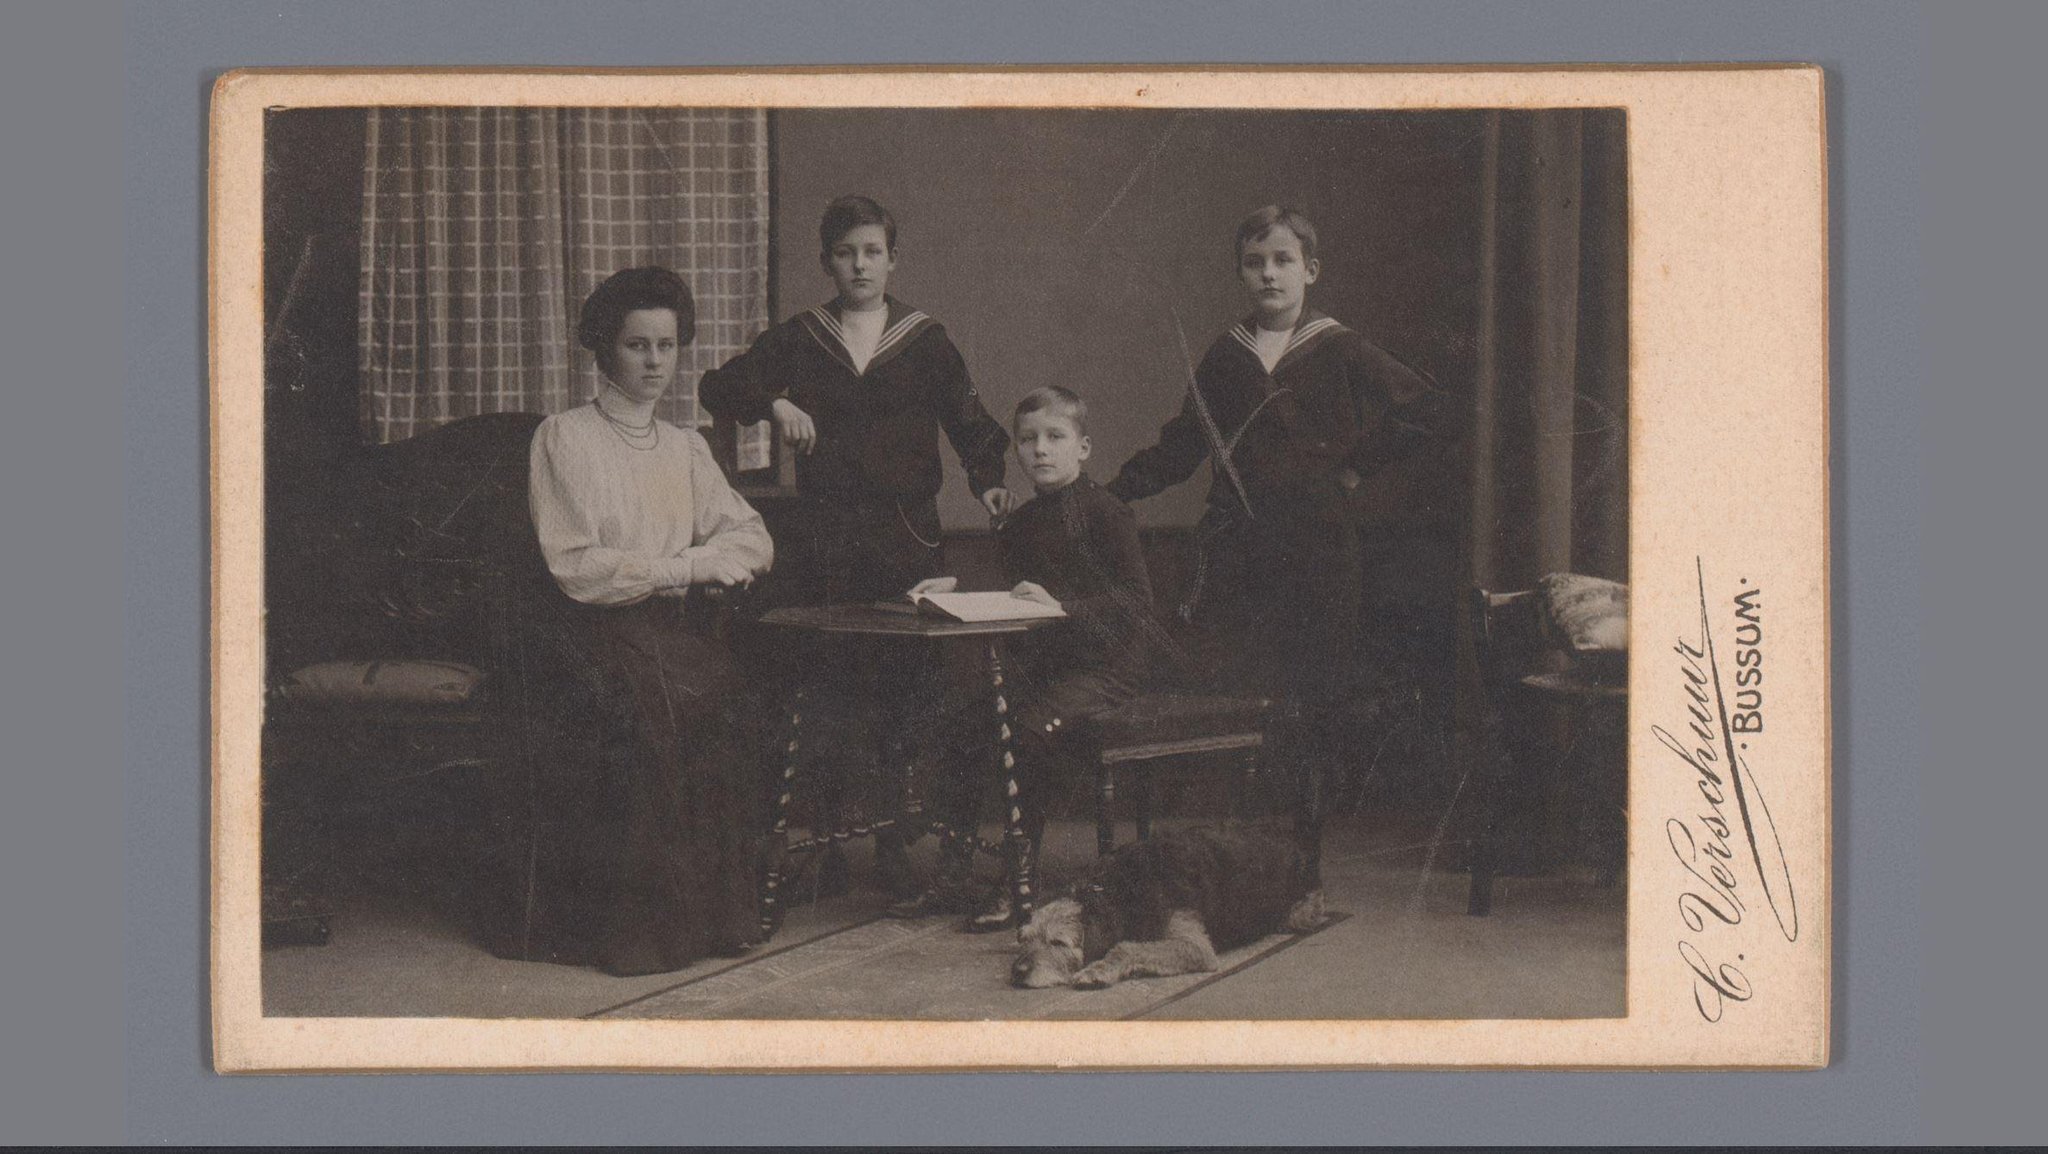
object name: carte de visite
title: Groepsportret van Johanna Geertruida, Lucas, Willem en Goverdus Henricus Jonker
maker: verschuur (fotograaf)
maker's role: fotograaf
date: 1910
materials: cardboard, photographic support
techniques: gelatin silver print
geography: bussum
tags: historical persons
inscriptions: annotation: ‘Hansje, Luc, Pim en Henricus Jonker’